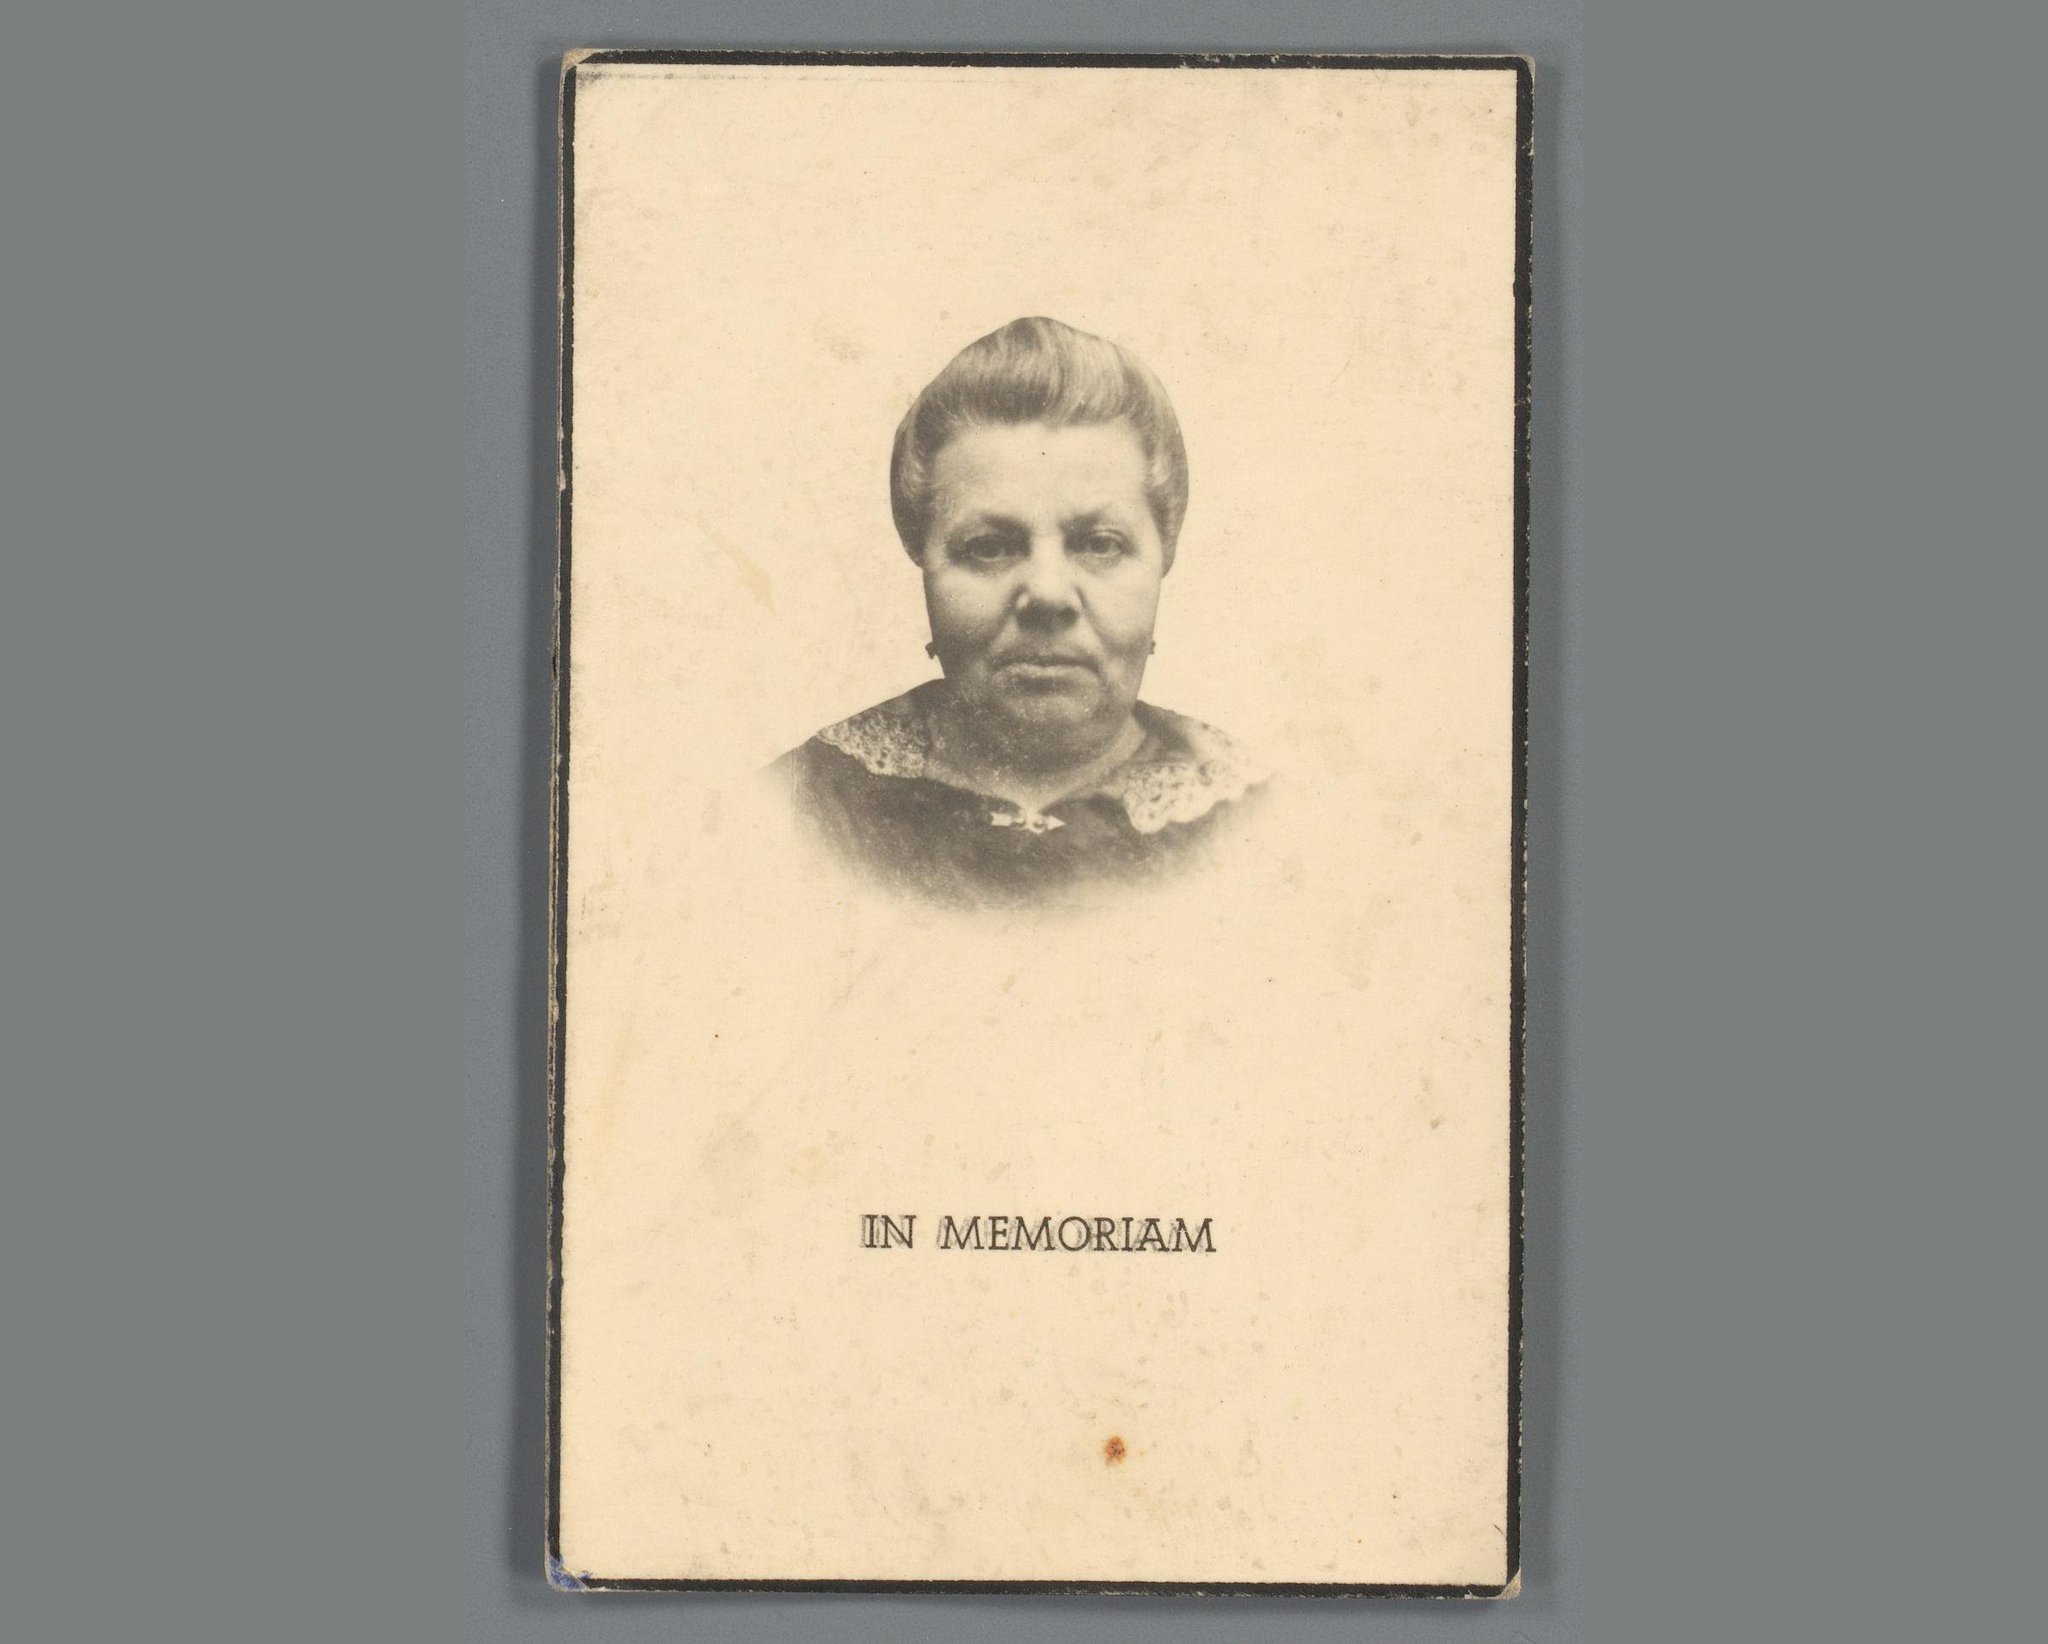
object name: prayer card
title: Portret van Johanna Nicolasina Maria Hanssen op bidprent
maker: Anonymous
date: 1940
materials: paper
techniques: gelatin silver print, letterpress printing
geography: den bosch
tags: historical persons, old woman, den bosch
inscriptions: inscription: ‘Bid voor de Ziel van Zaliger (...) Mijn Jezus barmhartigheid. (300 dg. afl.)’